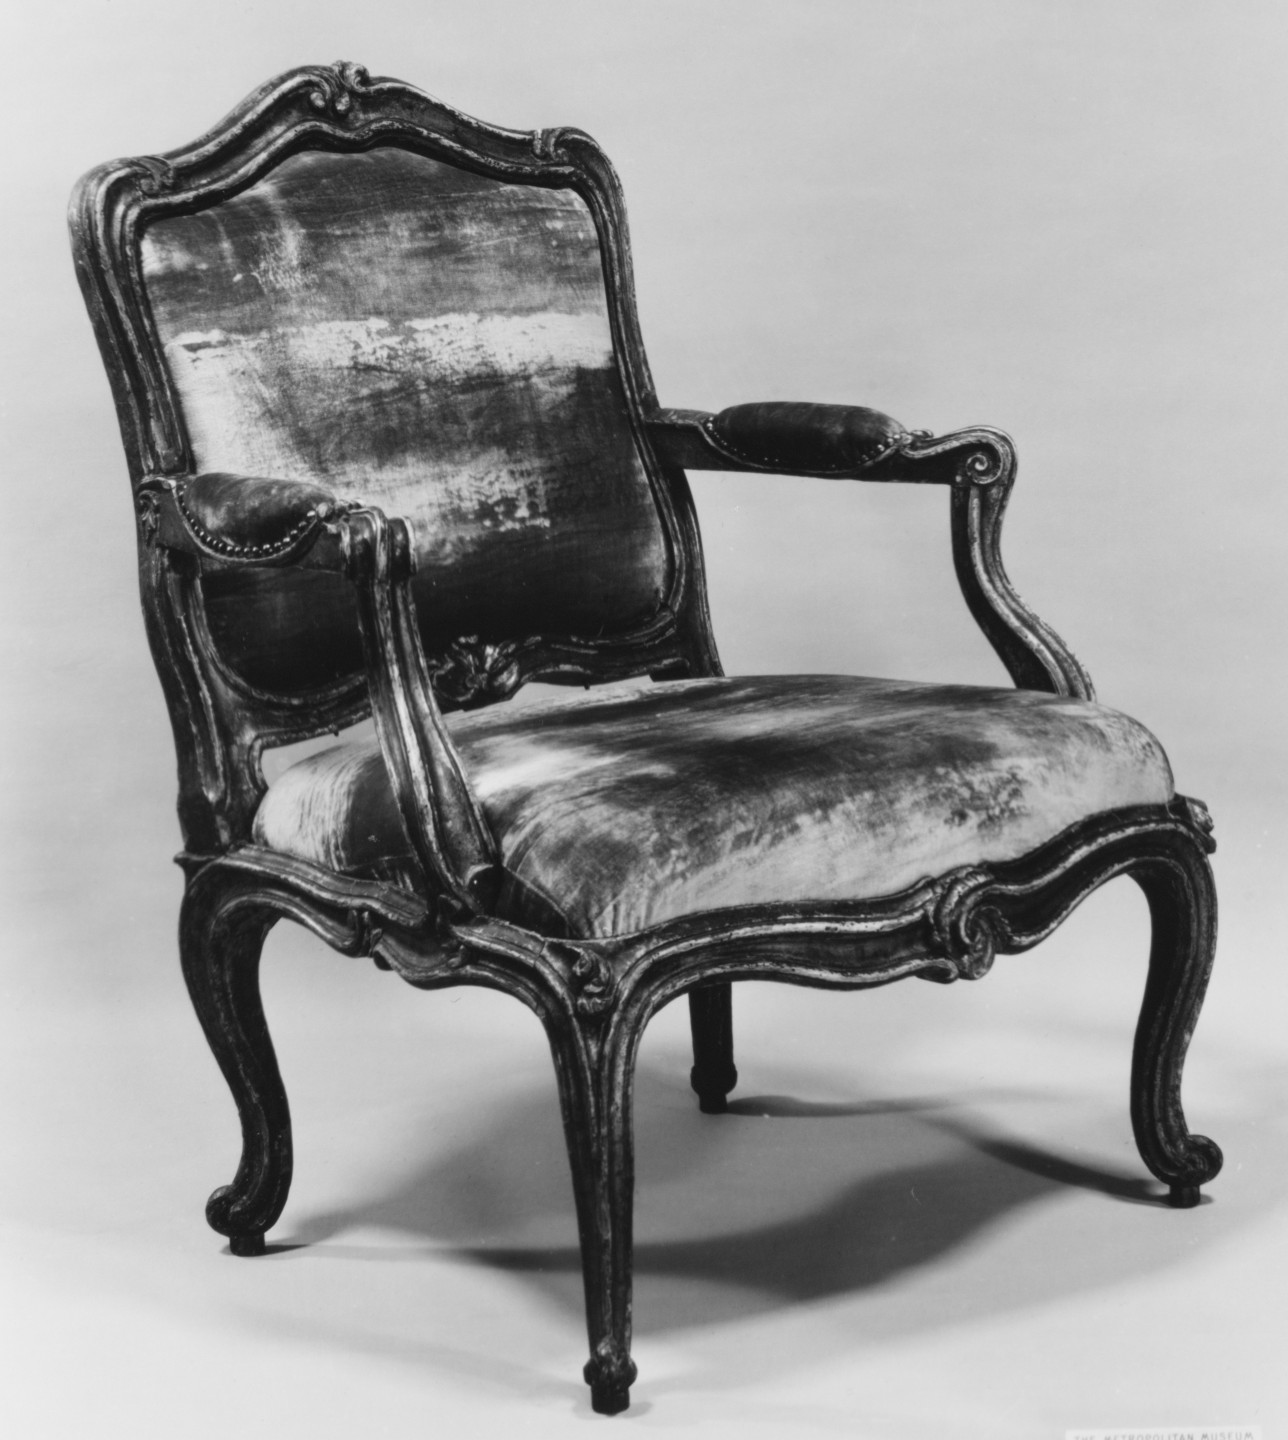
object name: armchair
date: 1734-1766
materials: velvet, wood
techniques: gilding